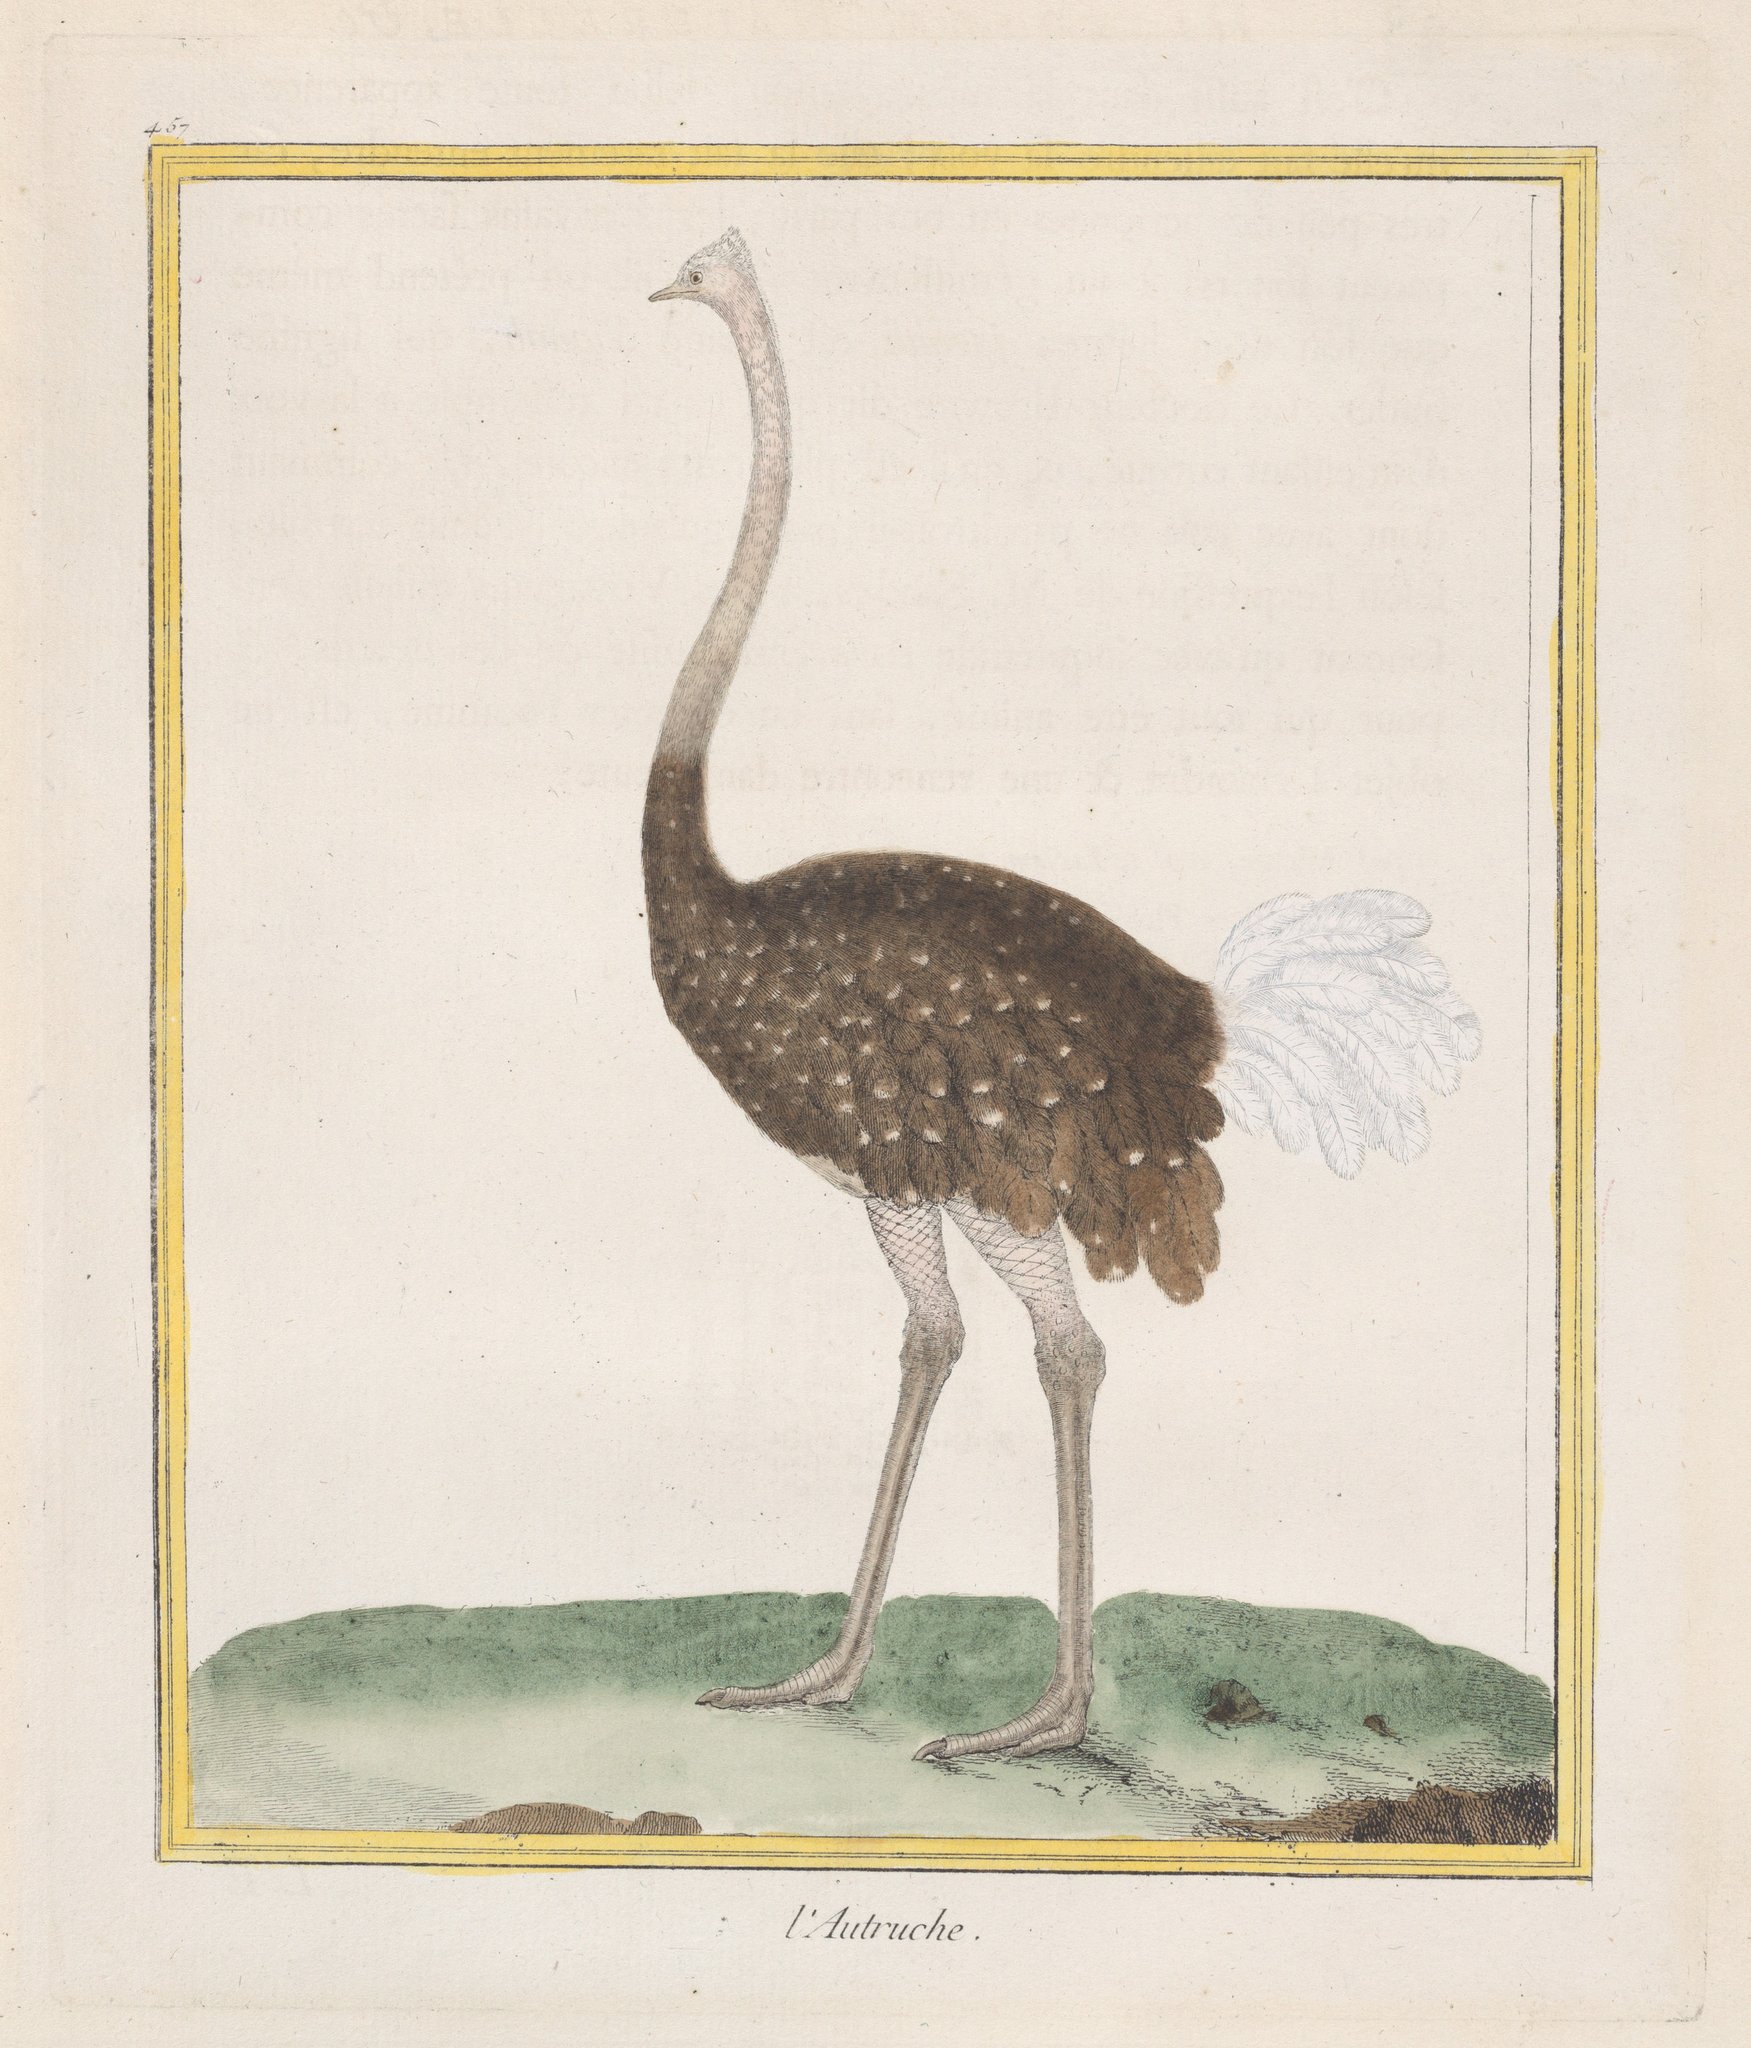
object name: print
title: Autruche (Ostrich), from "Histoire Naturelle de Oiseaux"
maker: françois nicolas martinet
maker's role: artist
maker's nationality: french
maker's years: 1731-1809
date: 1770-1786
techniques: engraving, etching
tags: birds